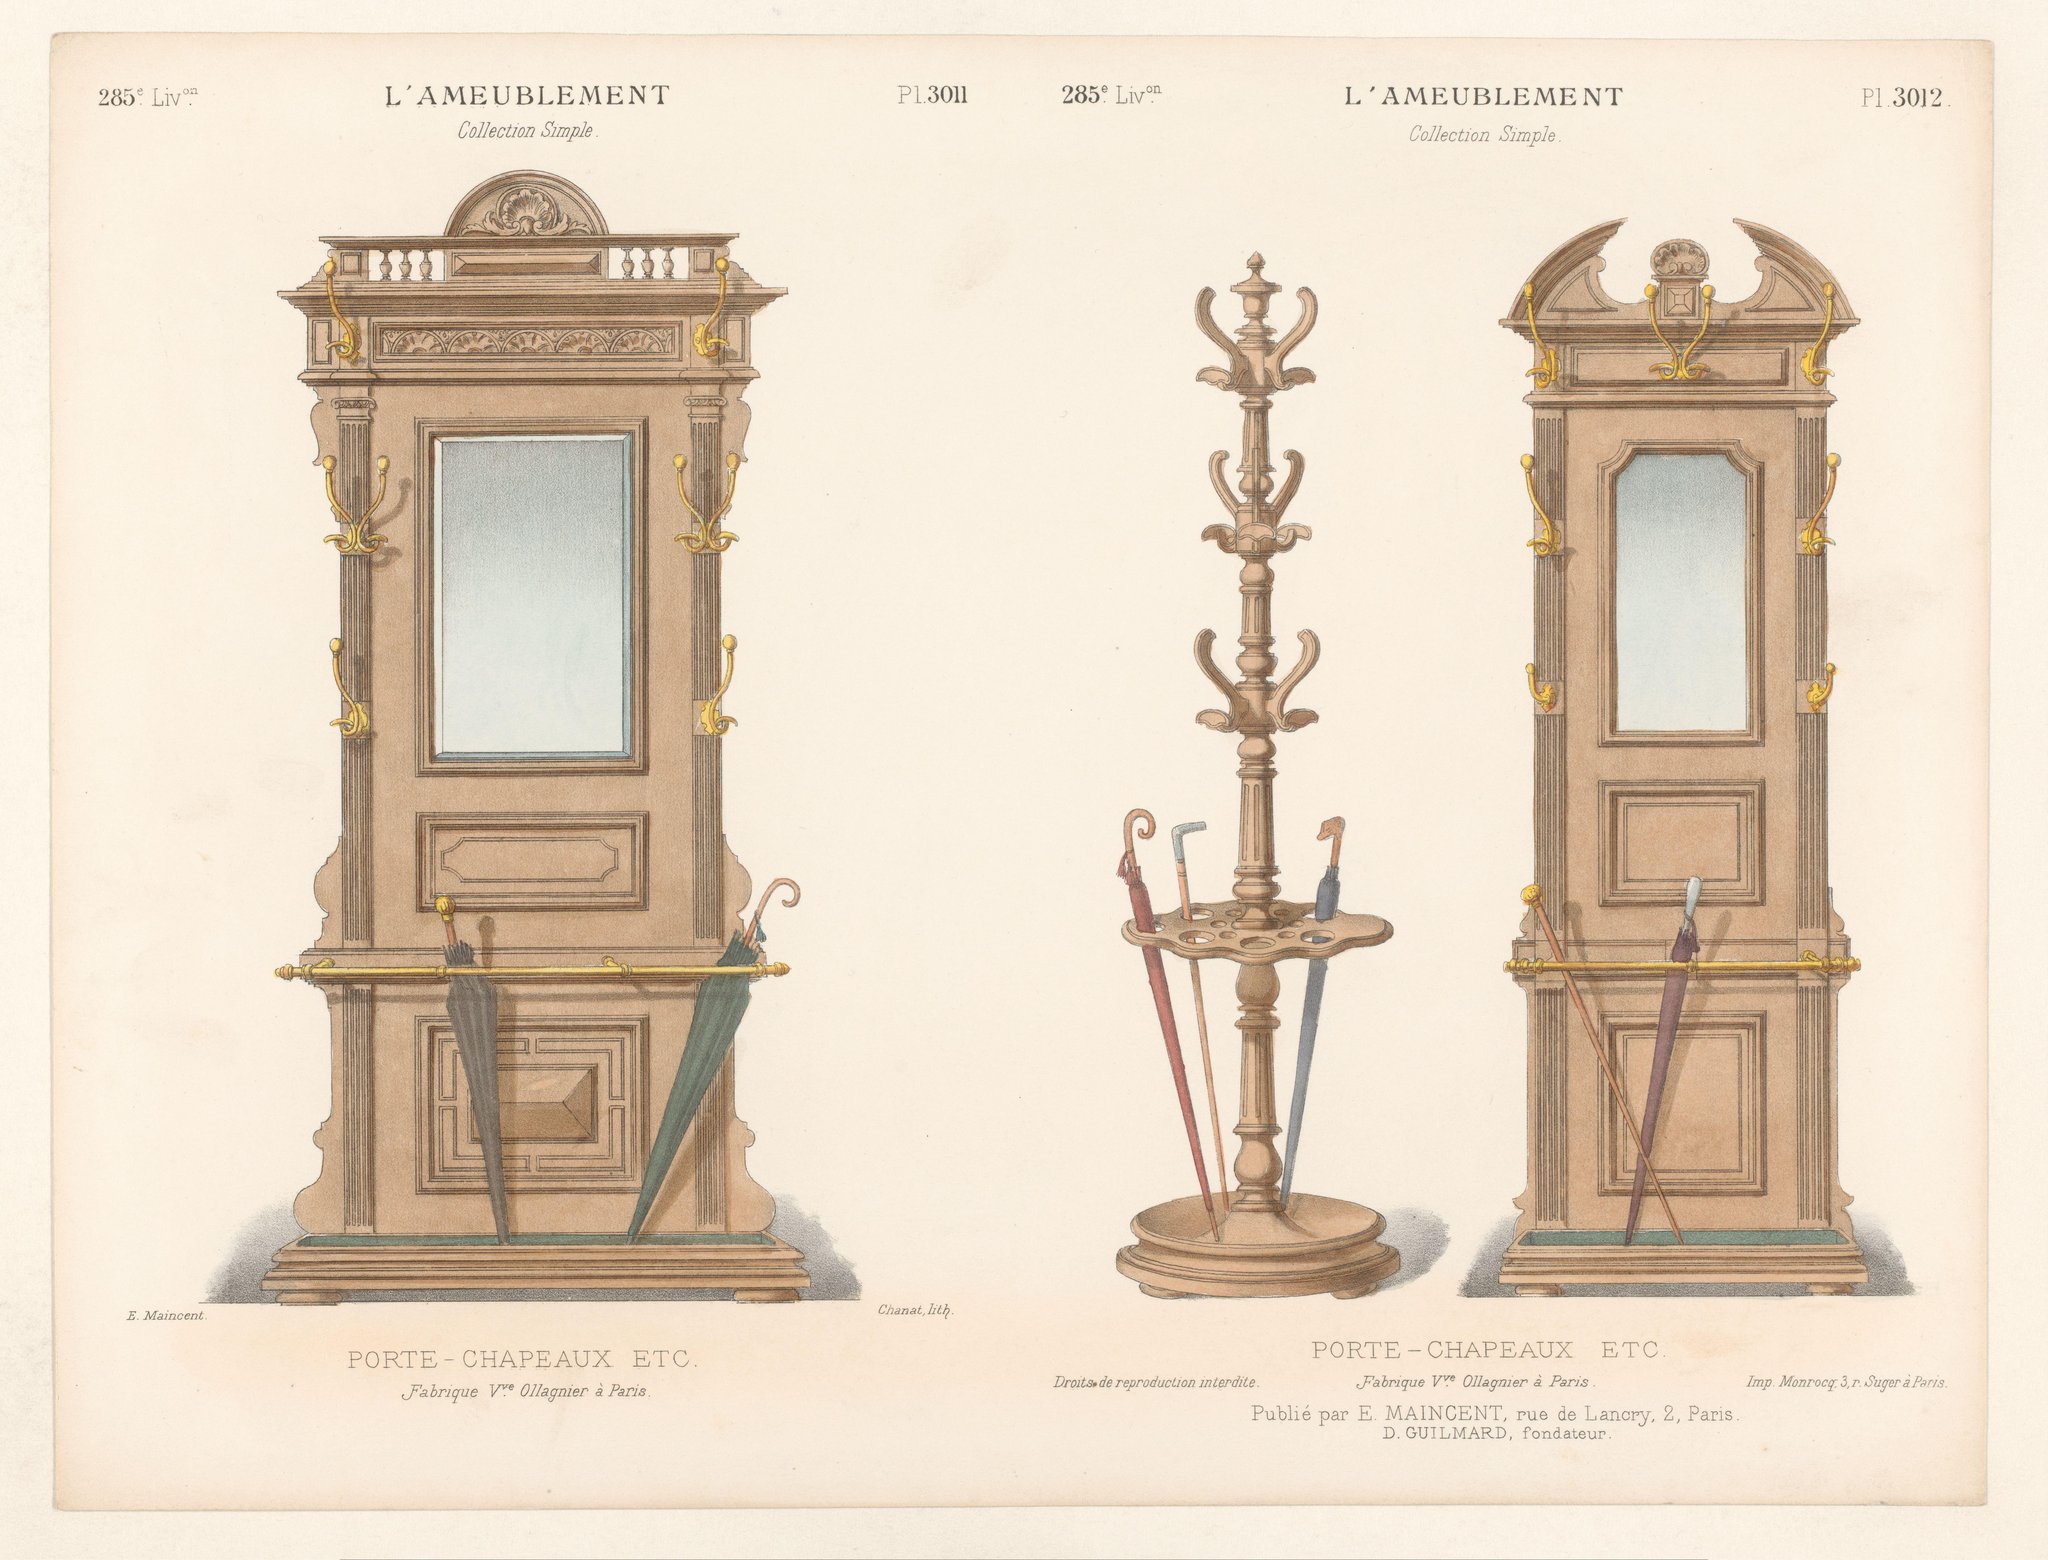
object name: print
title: Porte-chapeaux etc.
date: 1885-1895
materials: paper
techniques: hand coloring, lithograph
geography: paris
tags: mirror, hanging clothes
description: Een kapstok met paraplustandaard en twee meubels met spiegel en kapstokken. Prent uit 285e Livraison.